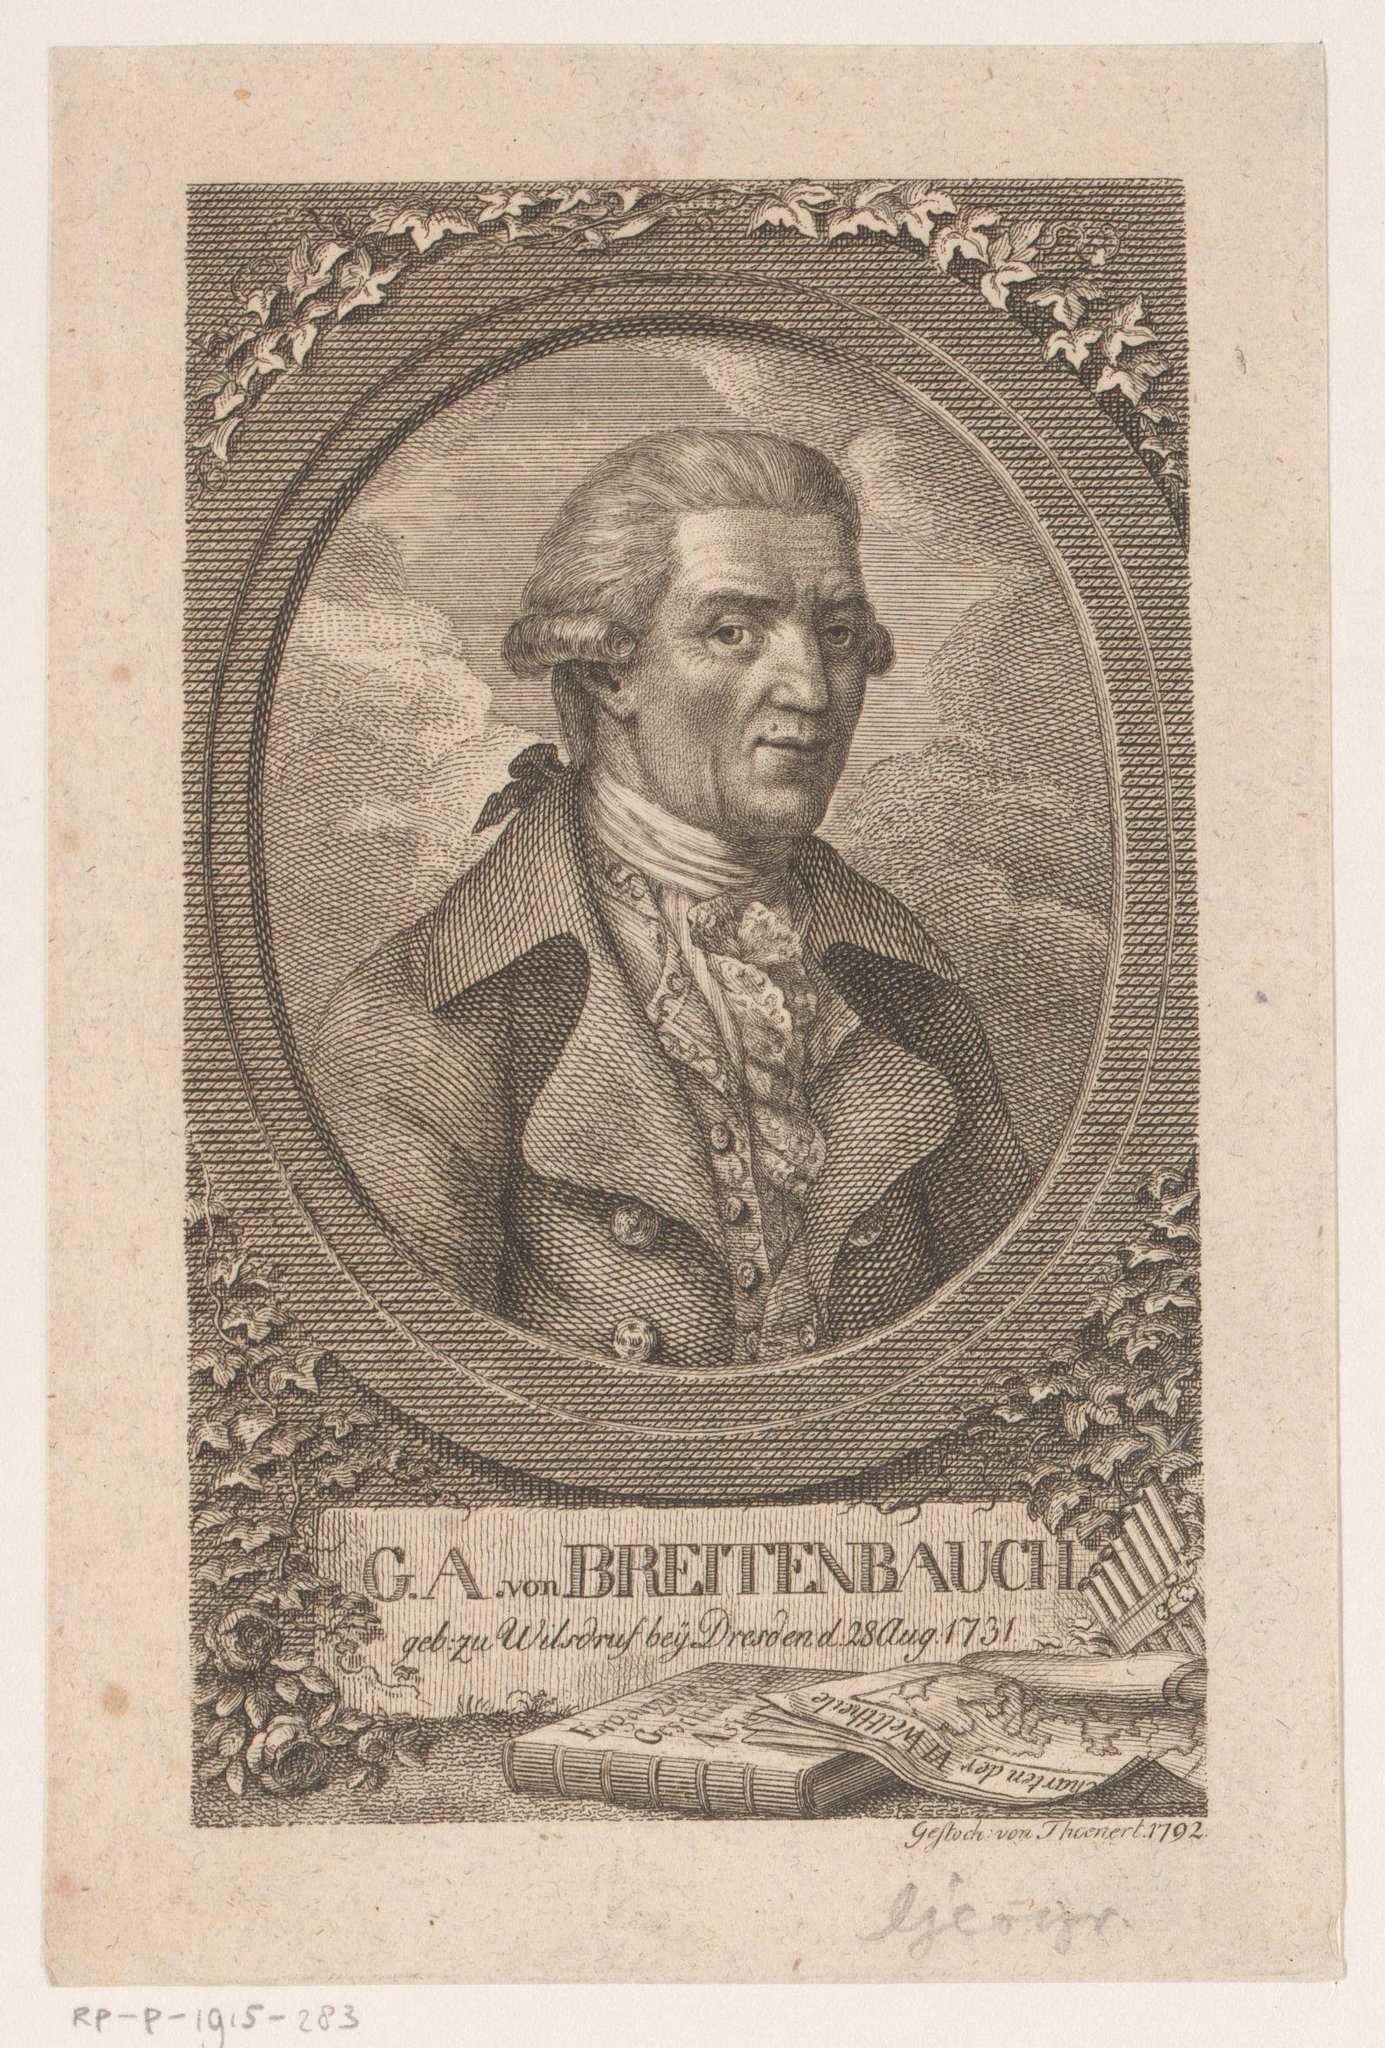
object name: print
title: Portret van Georg August von Breitenbauch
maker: medardus thoenert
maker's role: print maker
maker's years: 1754-1814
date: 1792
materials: paper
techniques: engraving, etching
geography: germany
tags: historical persons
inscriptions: collector's mark: Lugt 2228